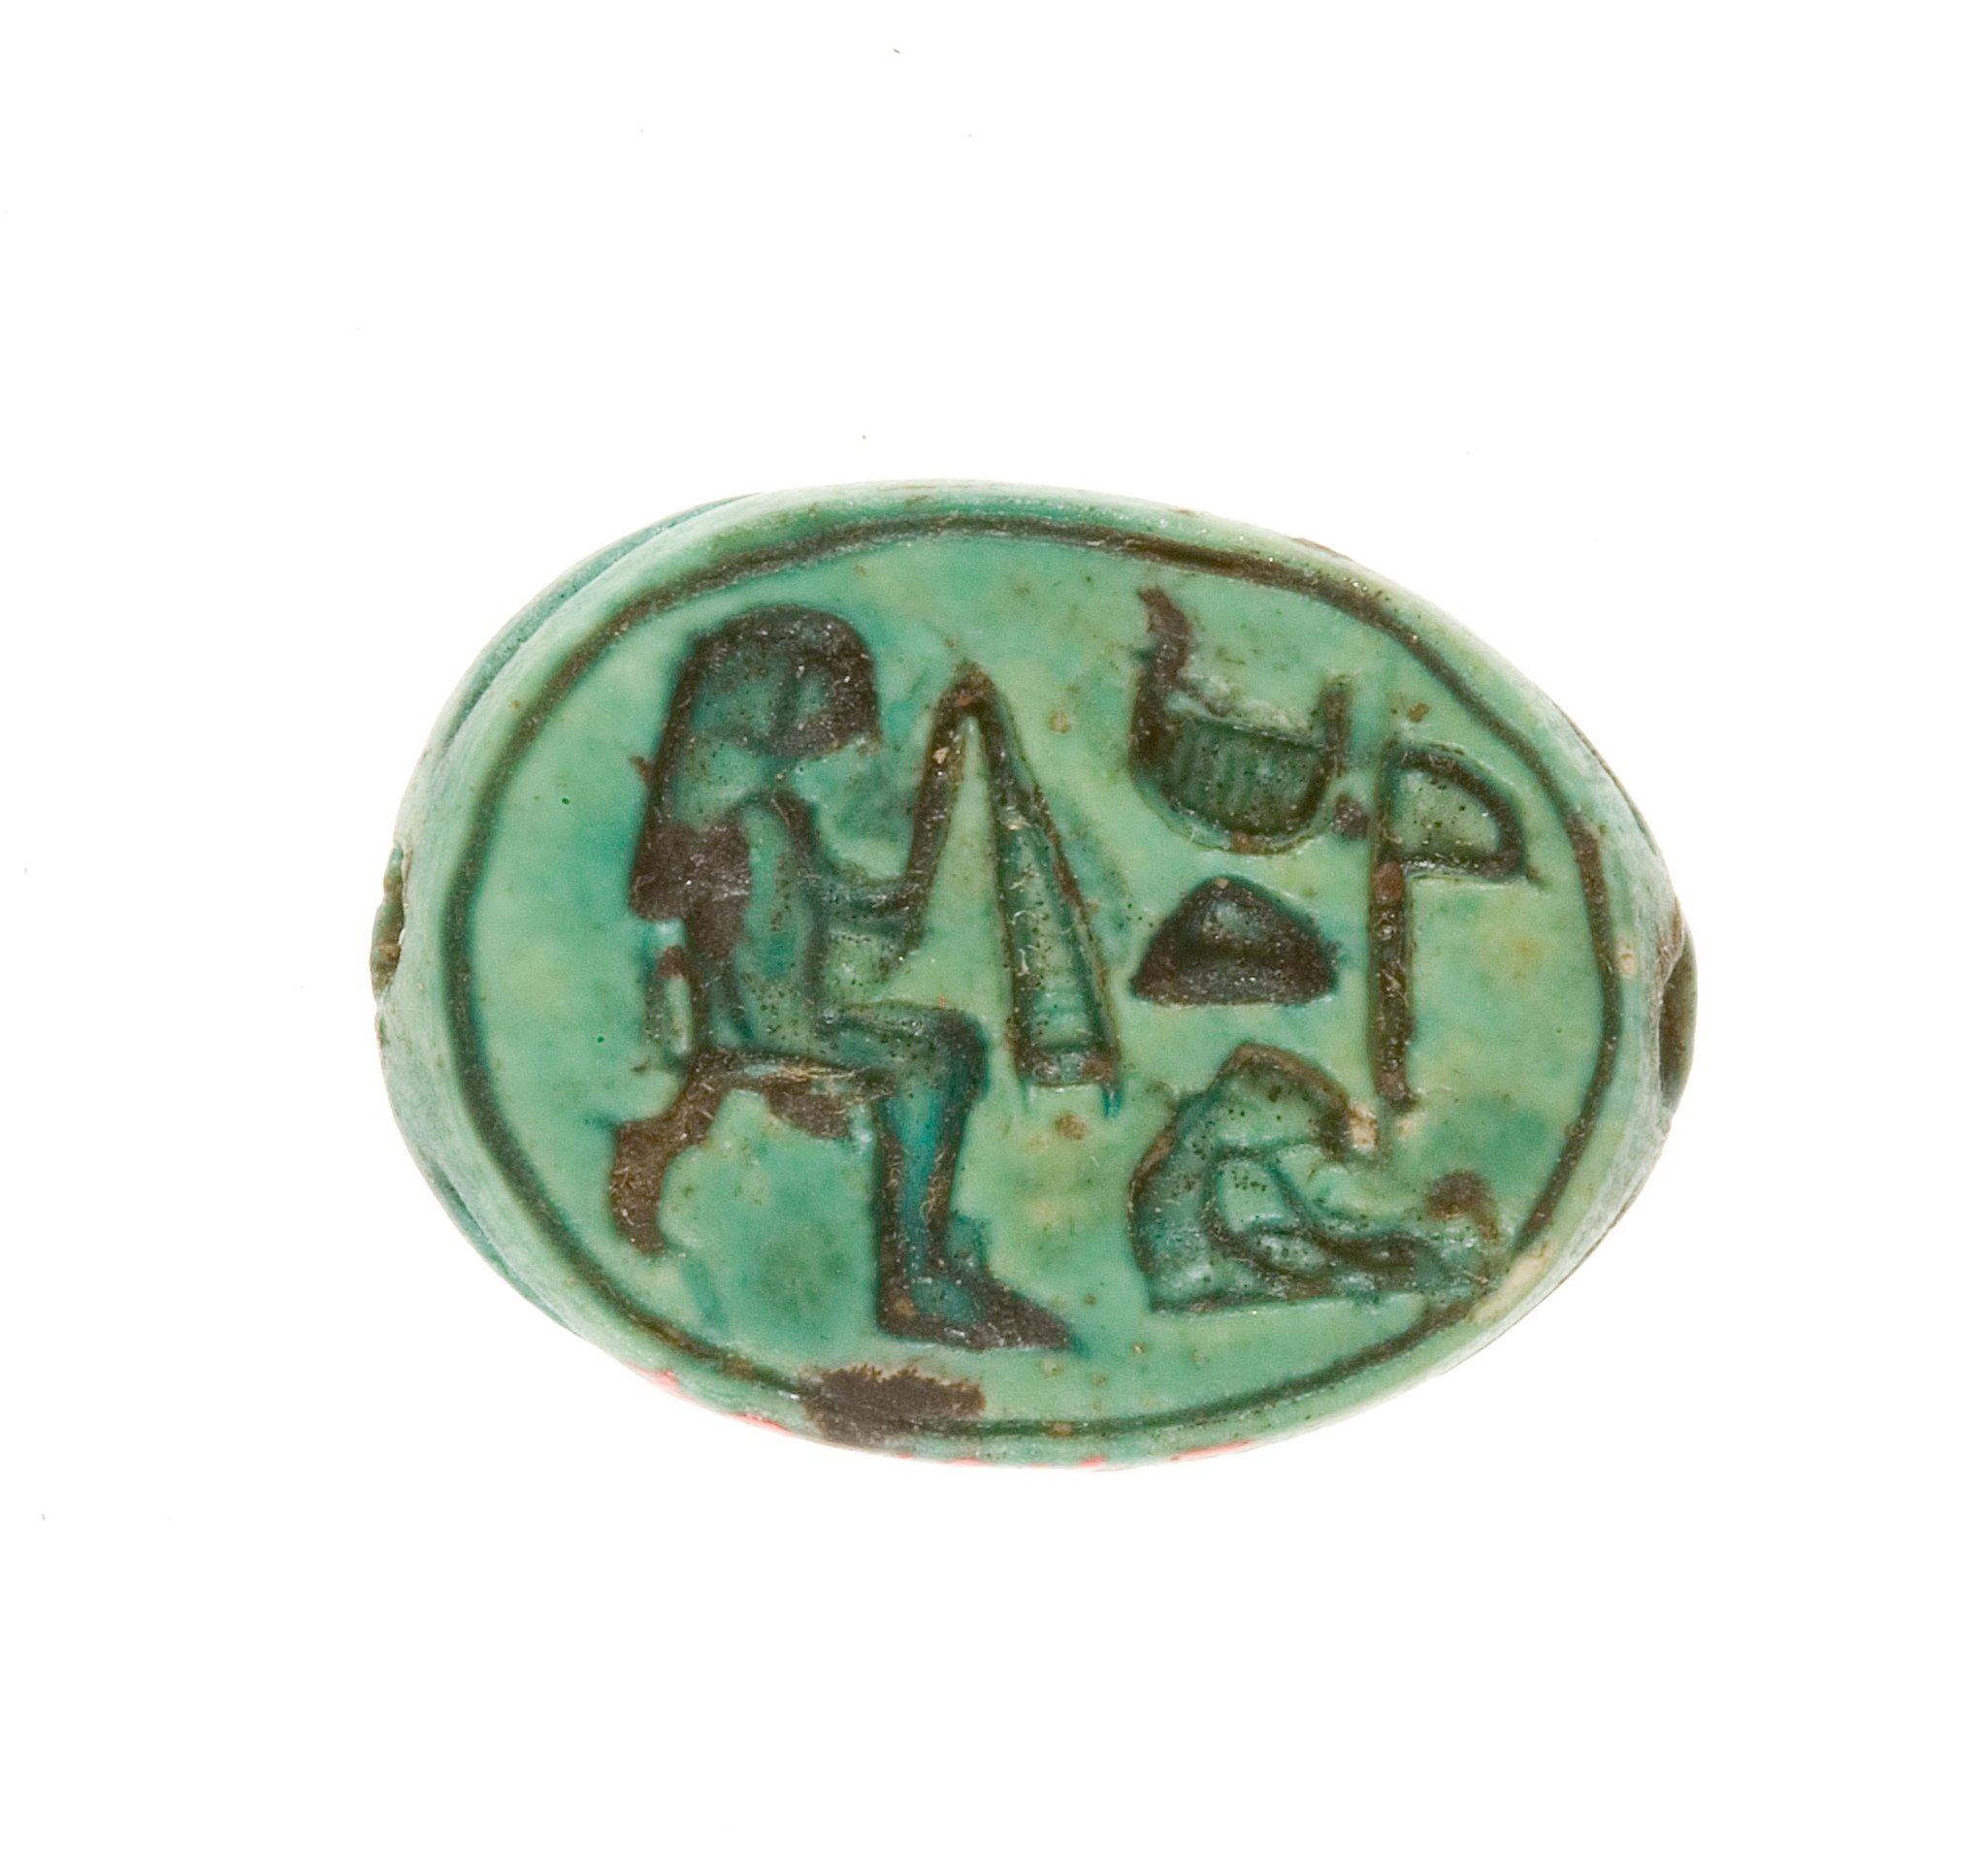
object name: scarab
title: Scarab Inscribed for the God's Wife Hatshepsut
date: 1479-1458 BCE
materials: stone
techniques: glazing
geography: egypt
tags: women,scarabs